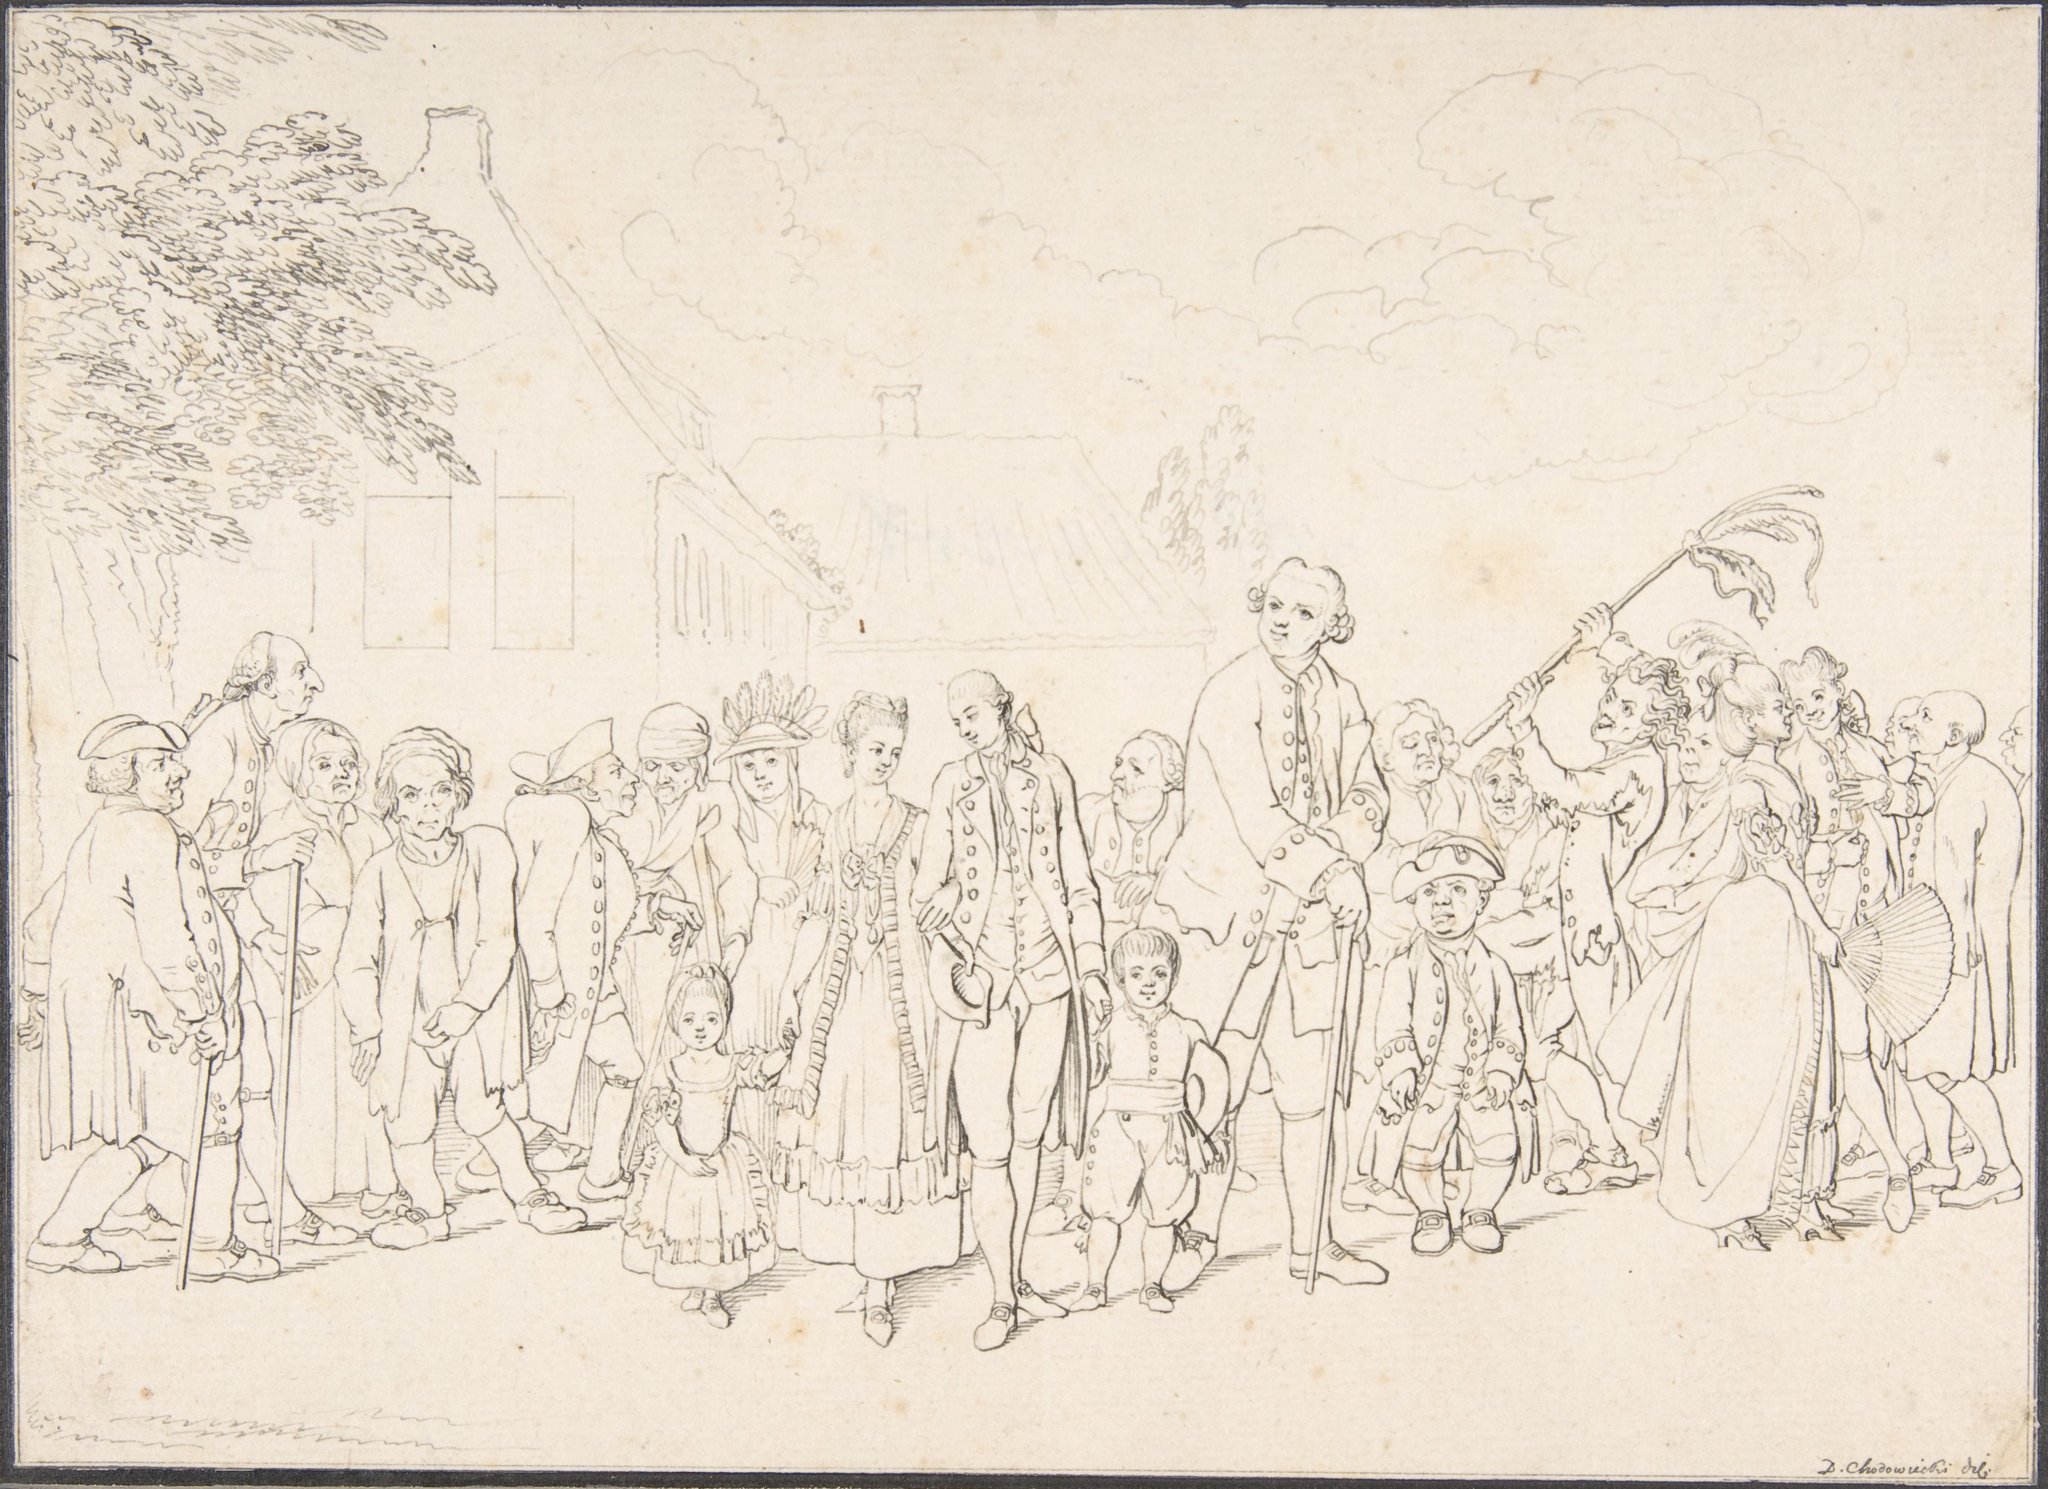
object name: drawing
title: An Aristocratic Family Visiting Paupers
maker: daniel nikolaus chodowiecki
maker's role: artist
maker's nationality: german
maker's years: 1726-1801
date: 1734-1800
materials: ink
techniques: pen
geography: germany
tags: boys,girls,men,women,family